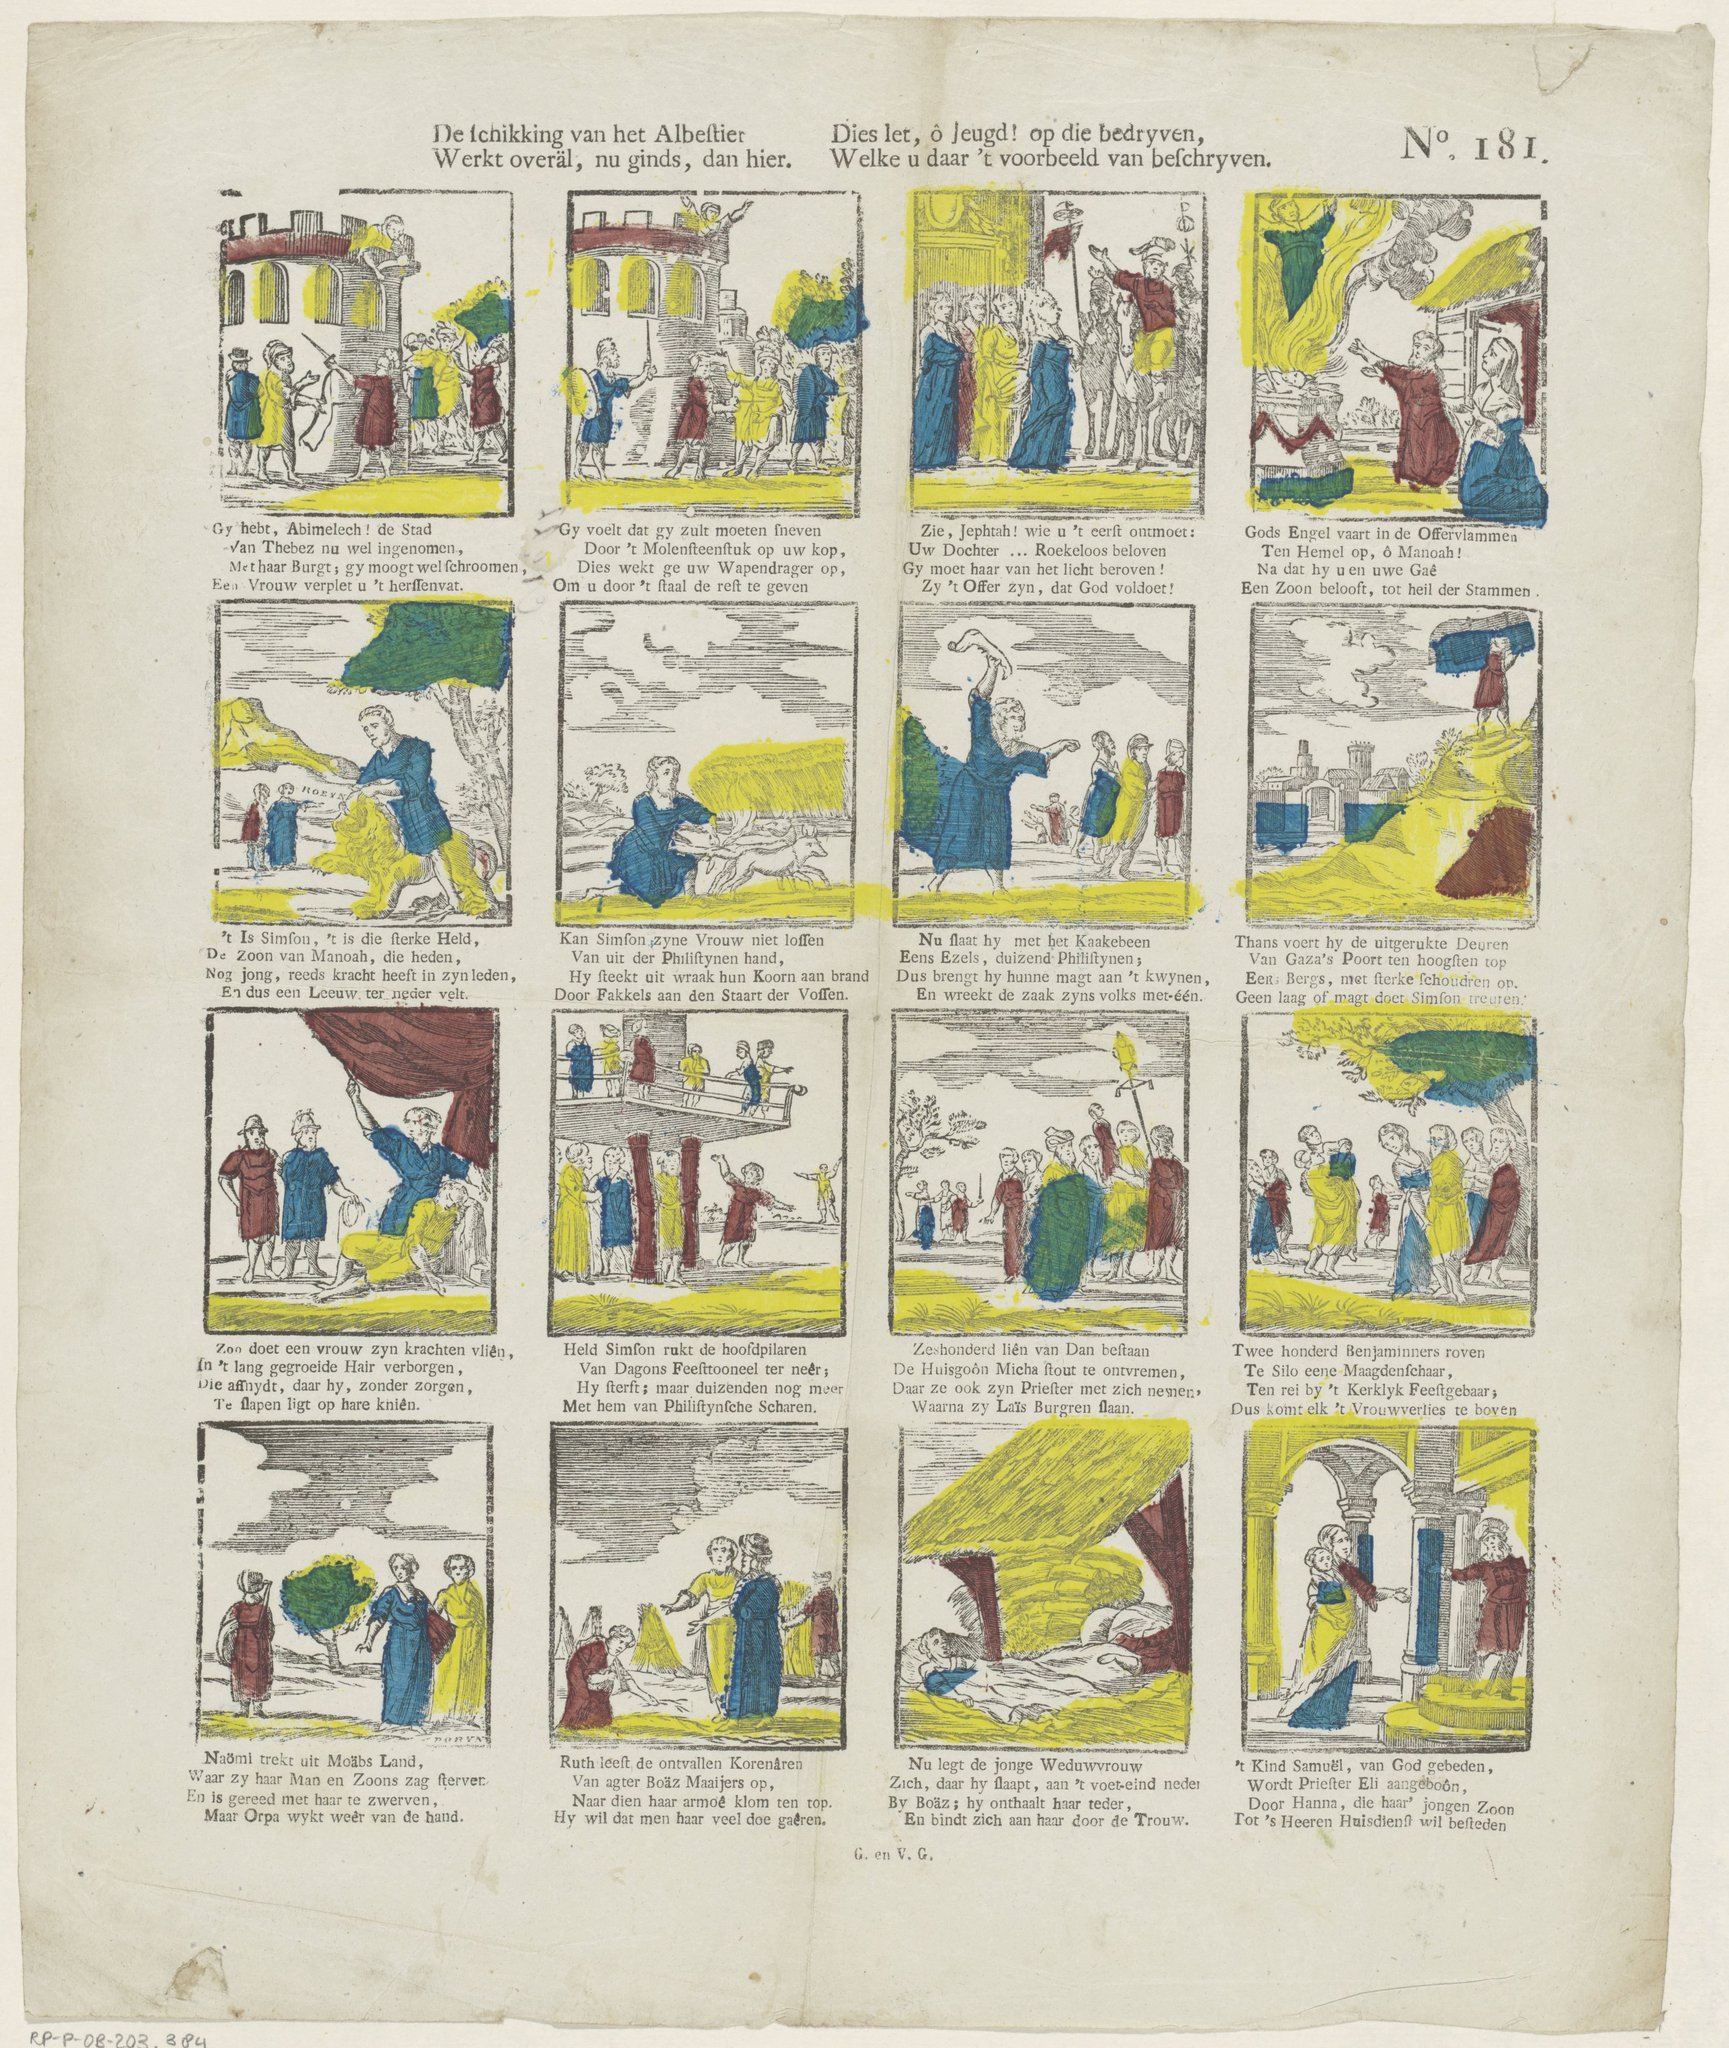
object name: popular print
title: De schikking van het Albestier / Werkt overäl, nu ginds, dan hier / Dies let, ô jeugd! op die bedryven, / Welke u daar 't voorbeeld van beschryven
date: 1833-1900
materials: paper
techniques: colour, letterpress printing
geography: turnhout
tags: old testament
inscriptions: collector's mark: Lugt 2760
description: Blad met 16 voorstellingen uit het Oude Testament, zoals Simson die de leeuw doodt en de jonge Samuel die aan de priester Eli wordt gegeven. Onder elke afbeelding een vierregelig vers. Genummerd rechtsboven: No. 181.